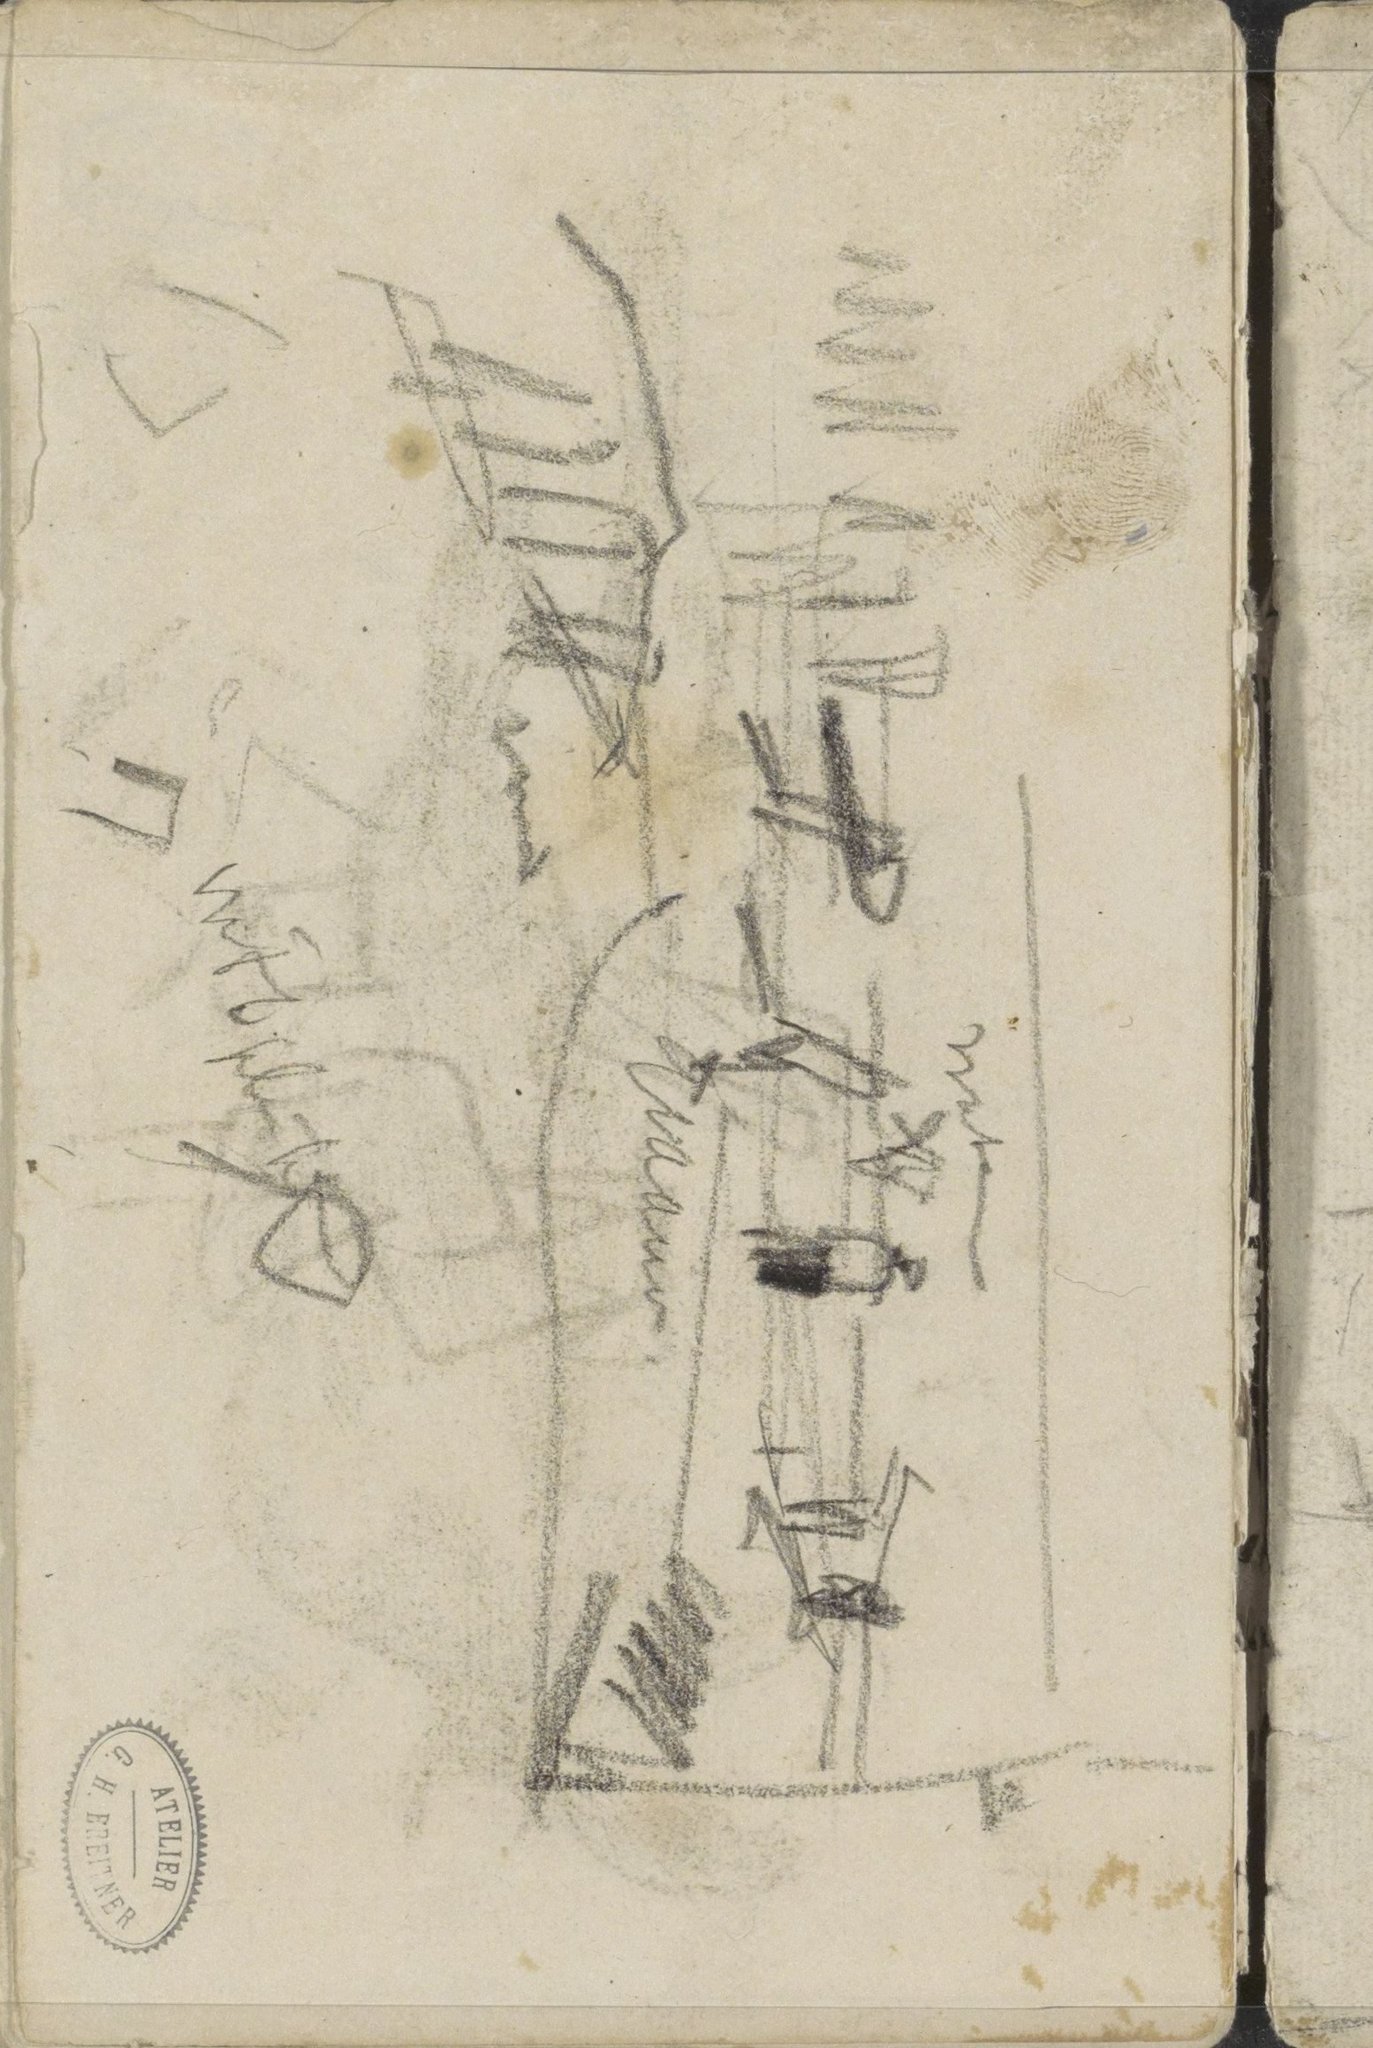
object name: sketchbook leaf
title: Figuur aan het water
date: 1880-1882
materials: chalk, paper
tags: adult man, canals, waters (in city)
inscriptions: workshop stamp: Lugt 291d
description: Blad 18 verso uit een schetsboek met 16 bladen.